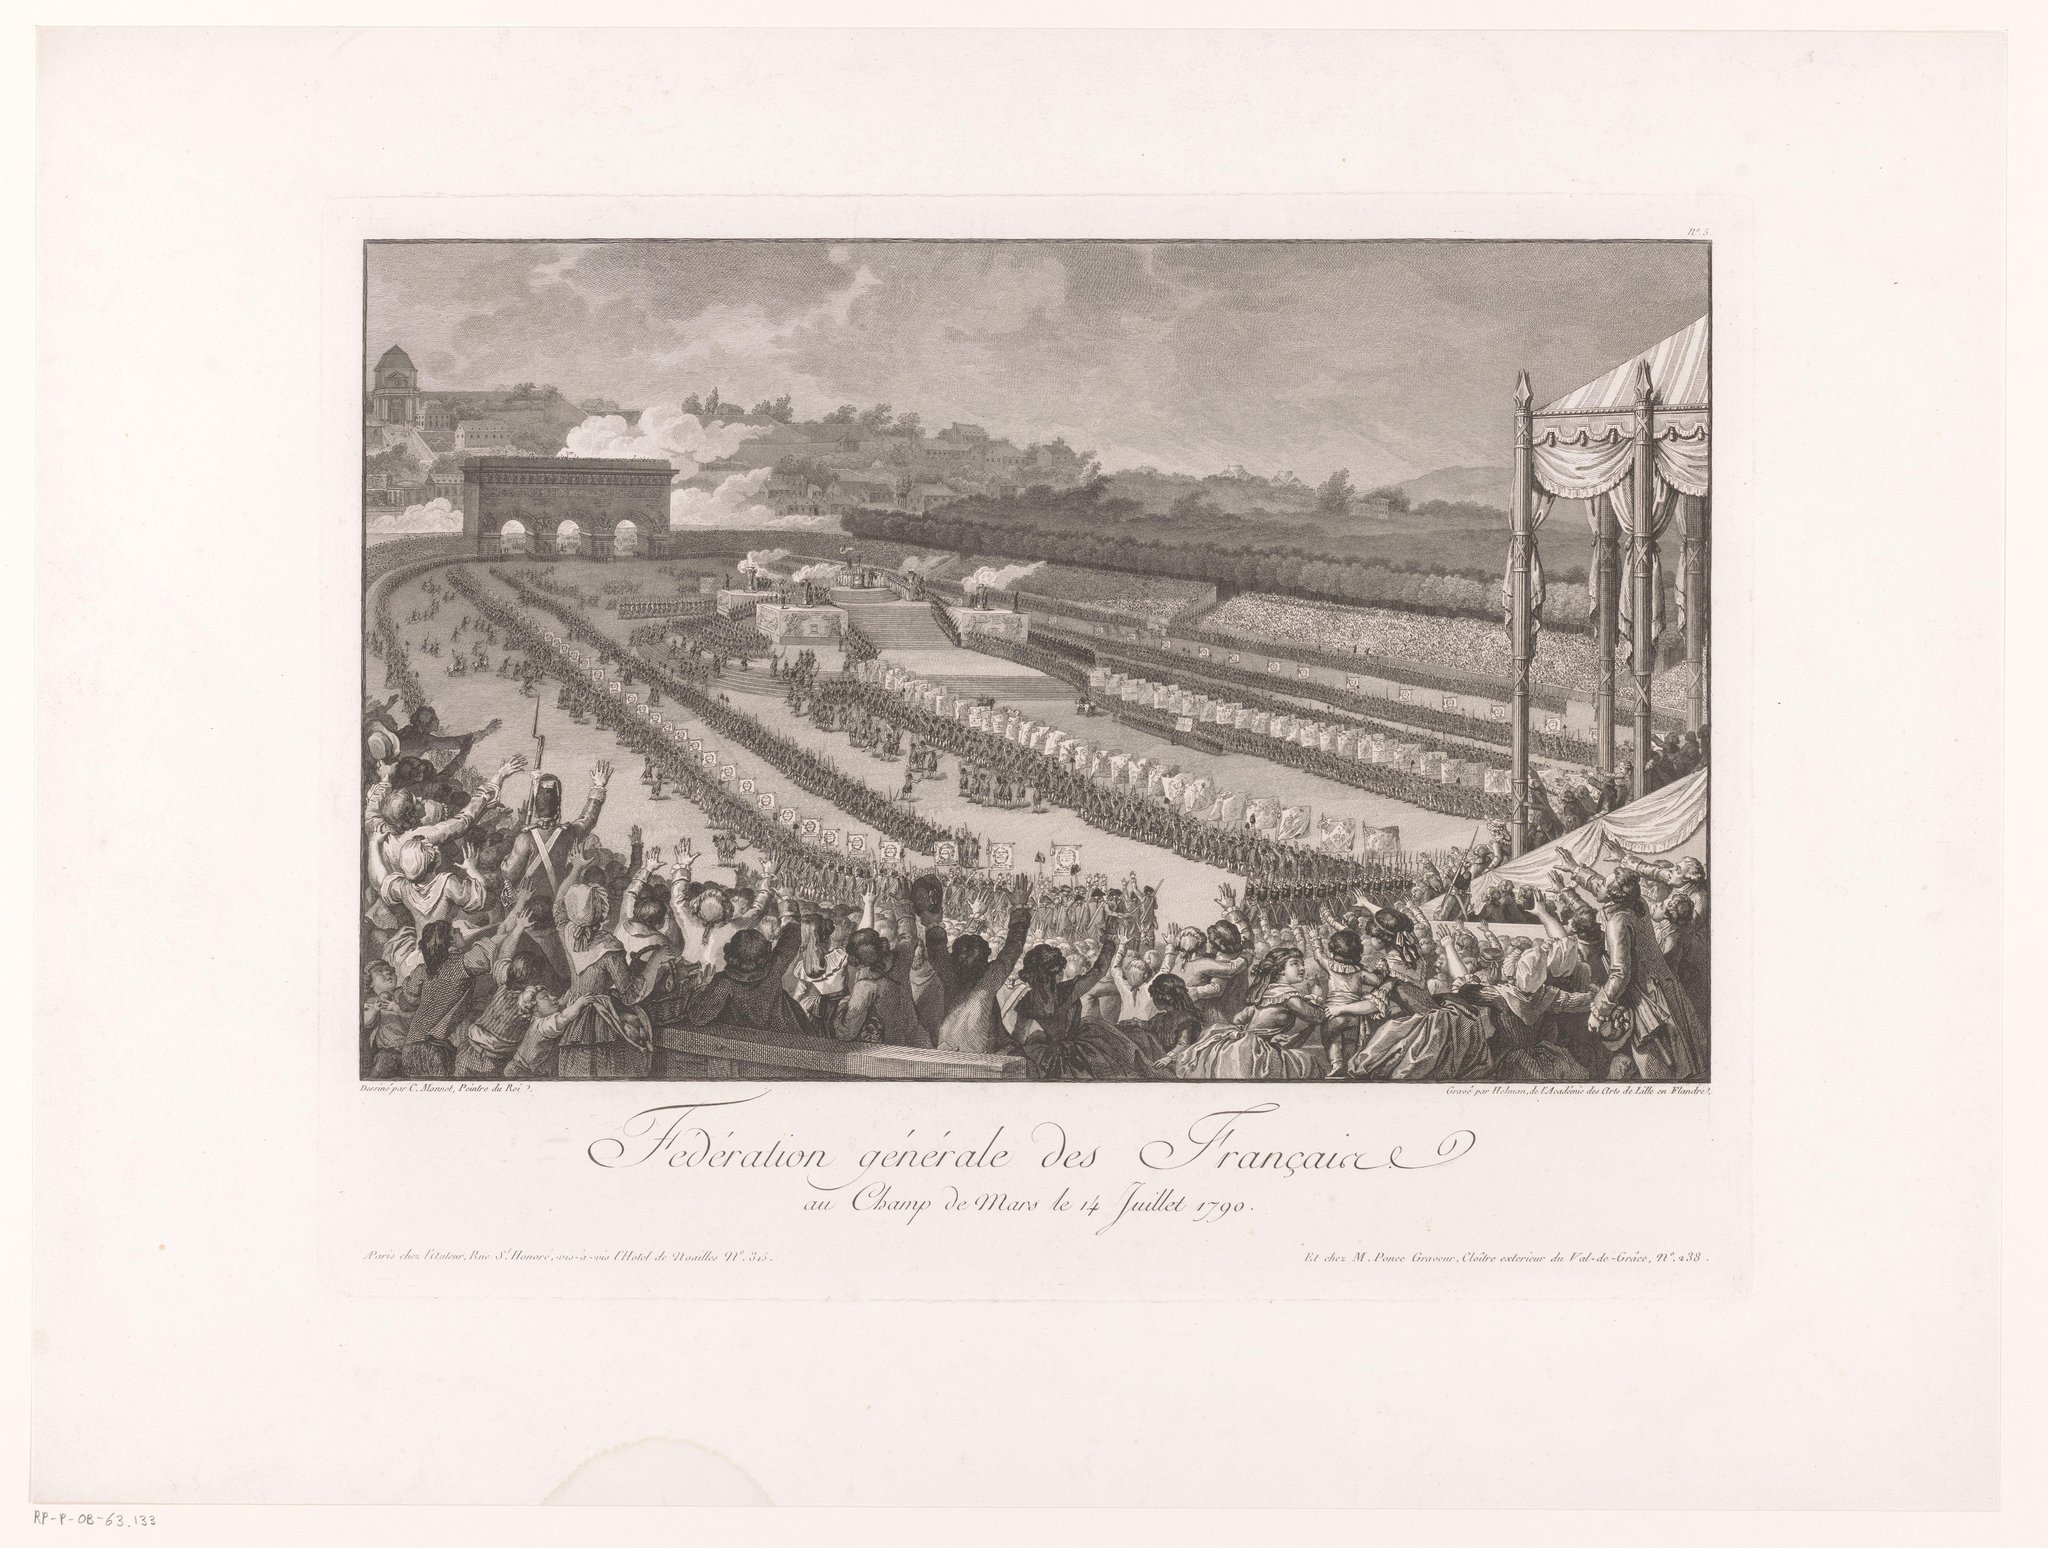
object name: print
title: Eenjarig jubileum van de Franse Revolutie op de Champ-de-Mars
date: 1793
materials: paper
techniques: etching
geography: paris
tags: military parade, pageant, commemoration, jubilee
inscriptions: collector's mark: Lugt 2228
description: Maakt deel uit van een serie getiteld 'La Révolution française depuis l'ouverture des États géneraux jusquáu 9 Brumaire' met vijftien prenten naar schilderijen met als onderwerp de eerste dagen van de Franse Revolutie. De serie werd verschillende malen uitgegeven, aanvankelijk onder de titel 'Les principales journées de la Révolution'. Voor meer informatie zie IFF 18e siècle, dl. 11, p. 291.